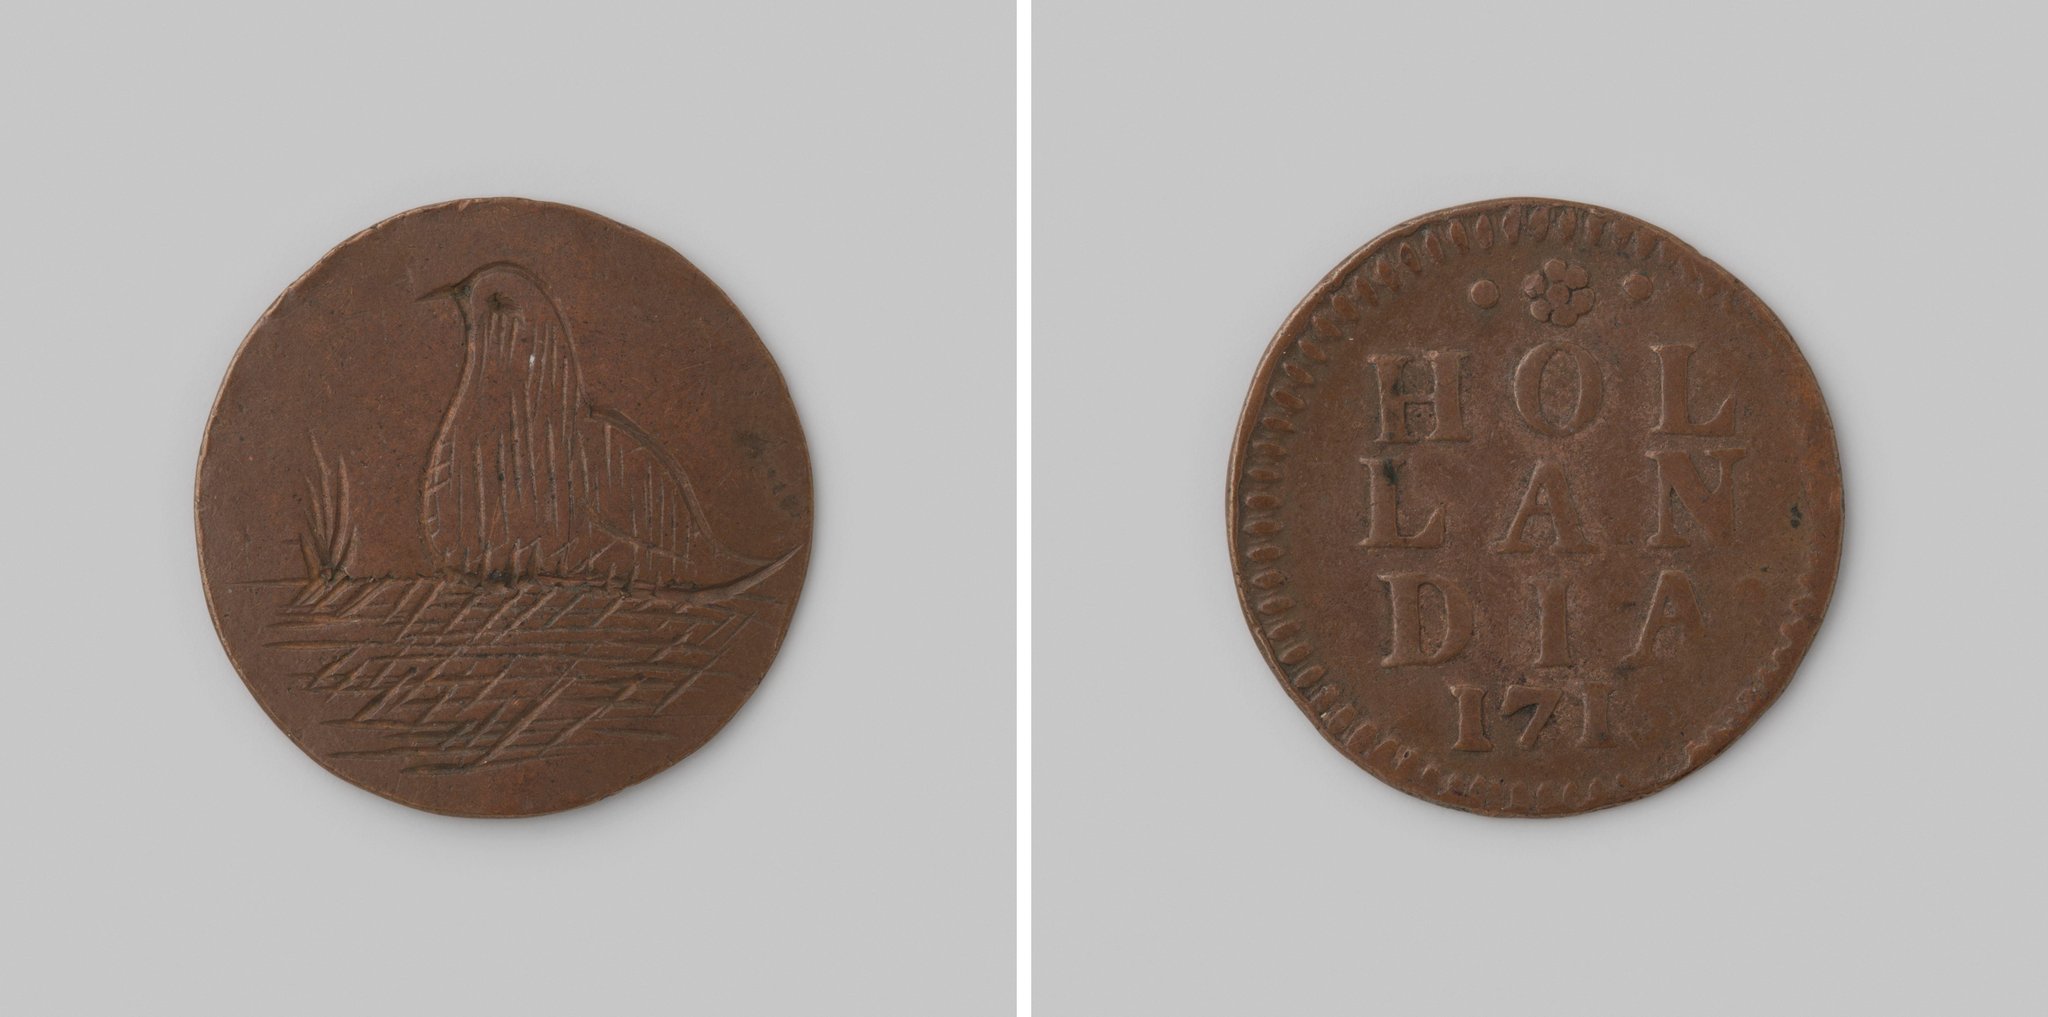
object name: coin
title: Hollandse duit, 1715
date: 1715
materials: copper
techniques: engraving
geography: dordrecht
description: Koperen munt. Voorzijde: watervogel in water. Keerzijde: opschrift: provincienaam in drie regels, daaronder jaartal. oorspronkelijke voorzijde is vervangen door gegraveerde beeldenaar.